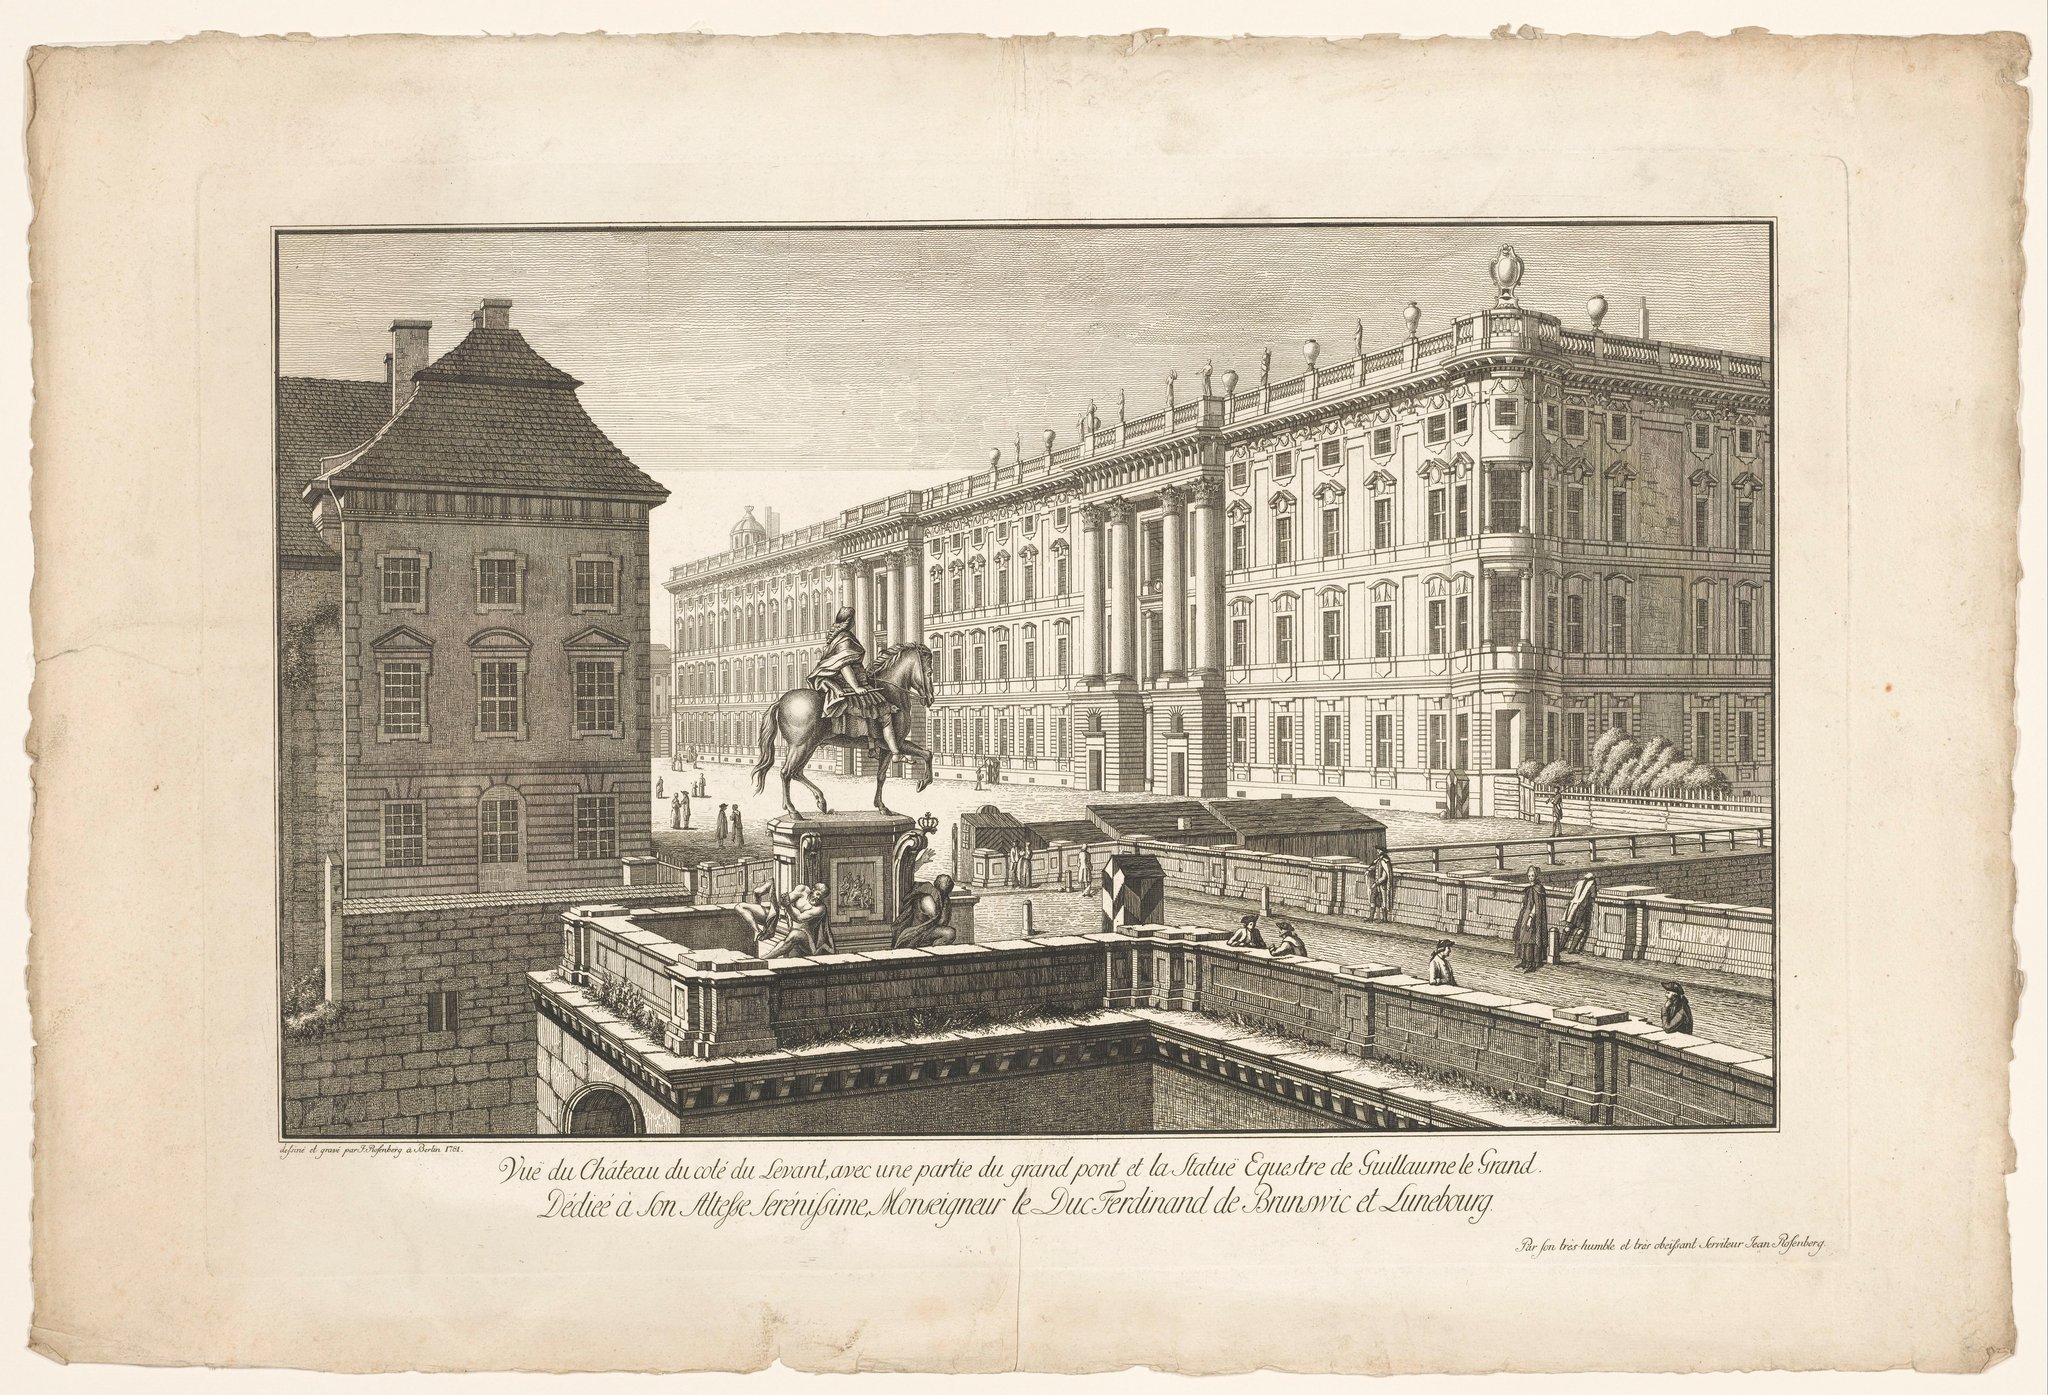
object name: print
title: Gezicht op het Berliner Stadtschloss vanaf een brug met een ruiterstandbeeld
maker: johann georg rosenberg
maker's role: print maker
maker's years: 1739-1808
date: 1781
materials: paper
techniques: engraving, etching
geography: berlin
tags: castle, equestrian statue, bridge in city across river, canal, etc.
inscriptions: collector's mark: Lugt 2228